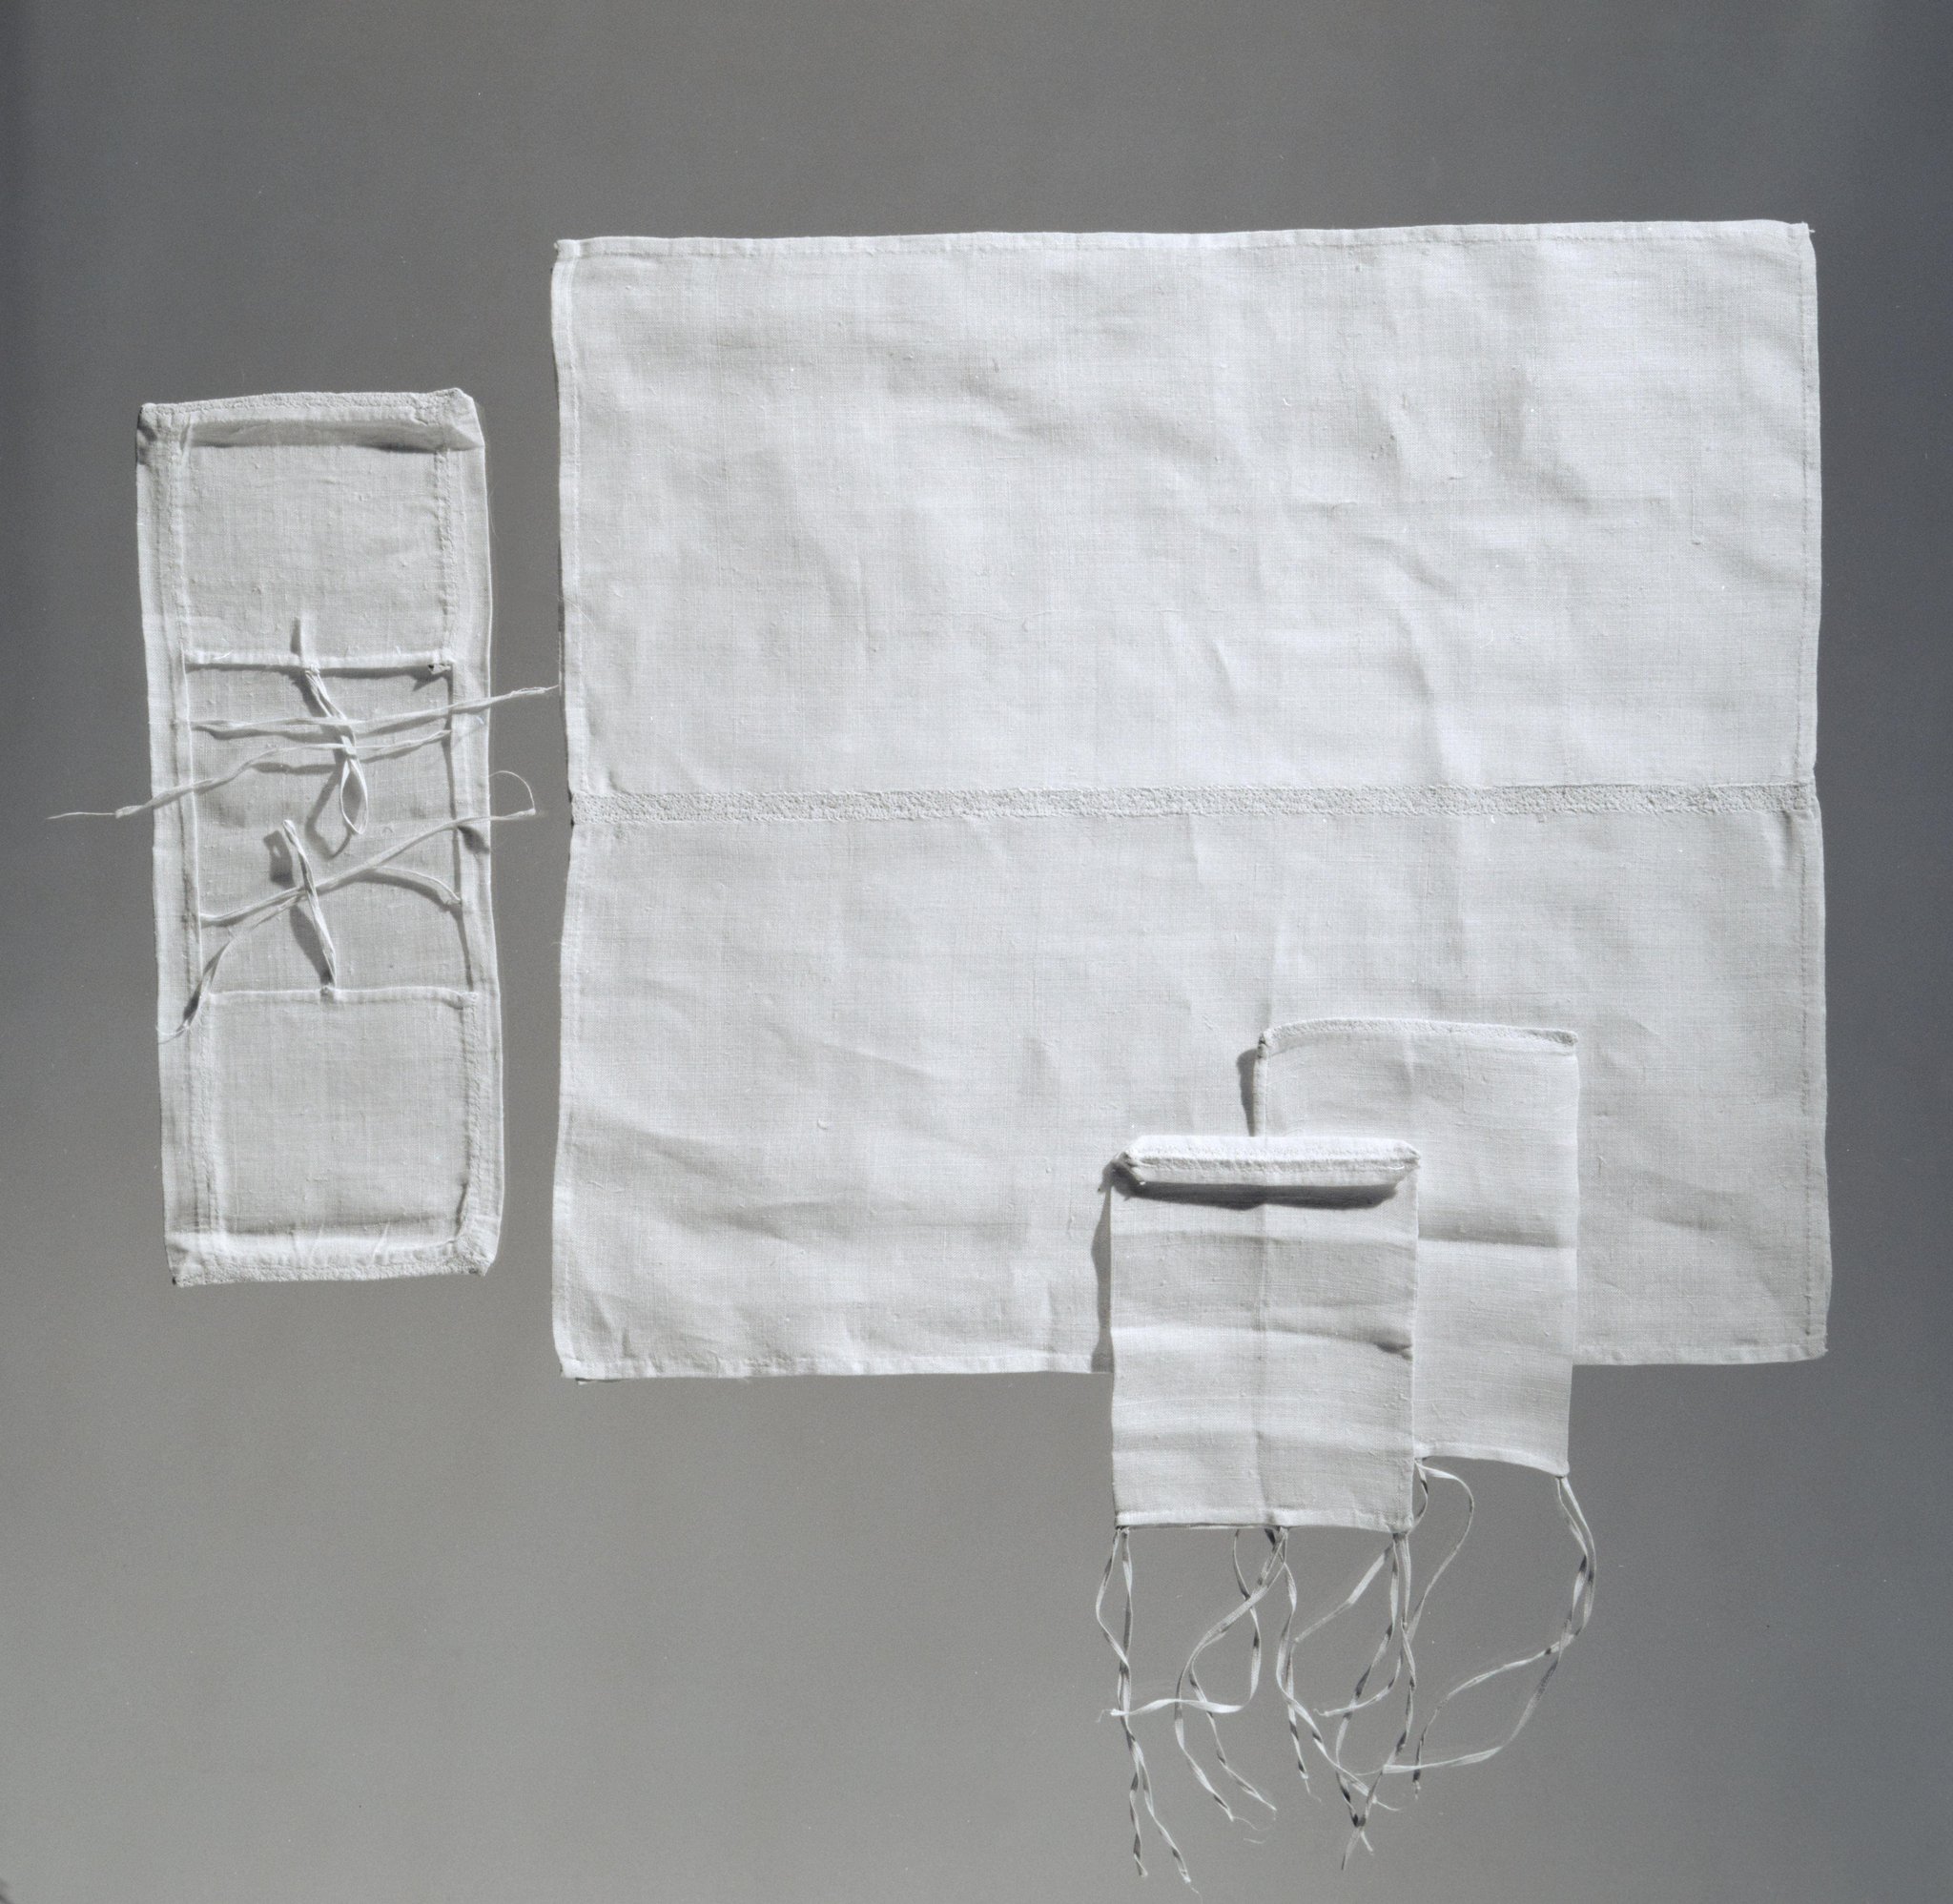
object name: miniature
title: Laken van linnen, met tussenzetsel van kloskant.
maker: Anonymous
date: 1676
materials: linen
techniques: lace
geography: amsterdam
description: Laken van zeer fijn linnen, aan alle zijden omzoomd. Het laken heeft een tussenzetsel van fijn kloskant midden over de hele lengte.